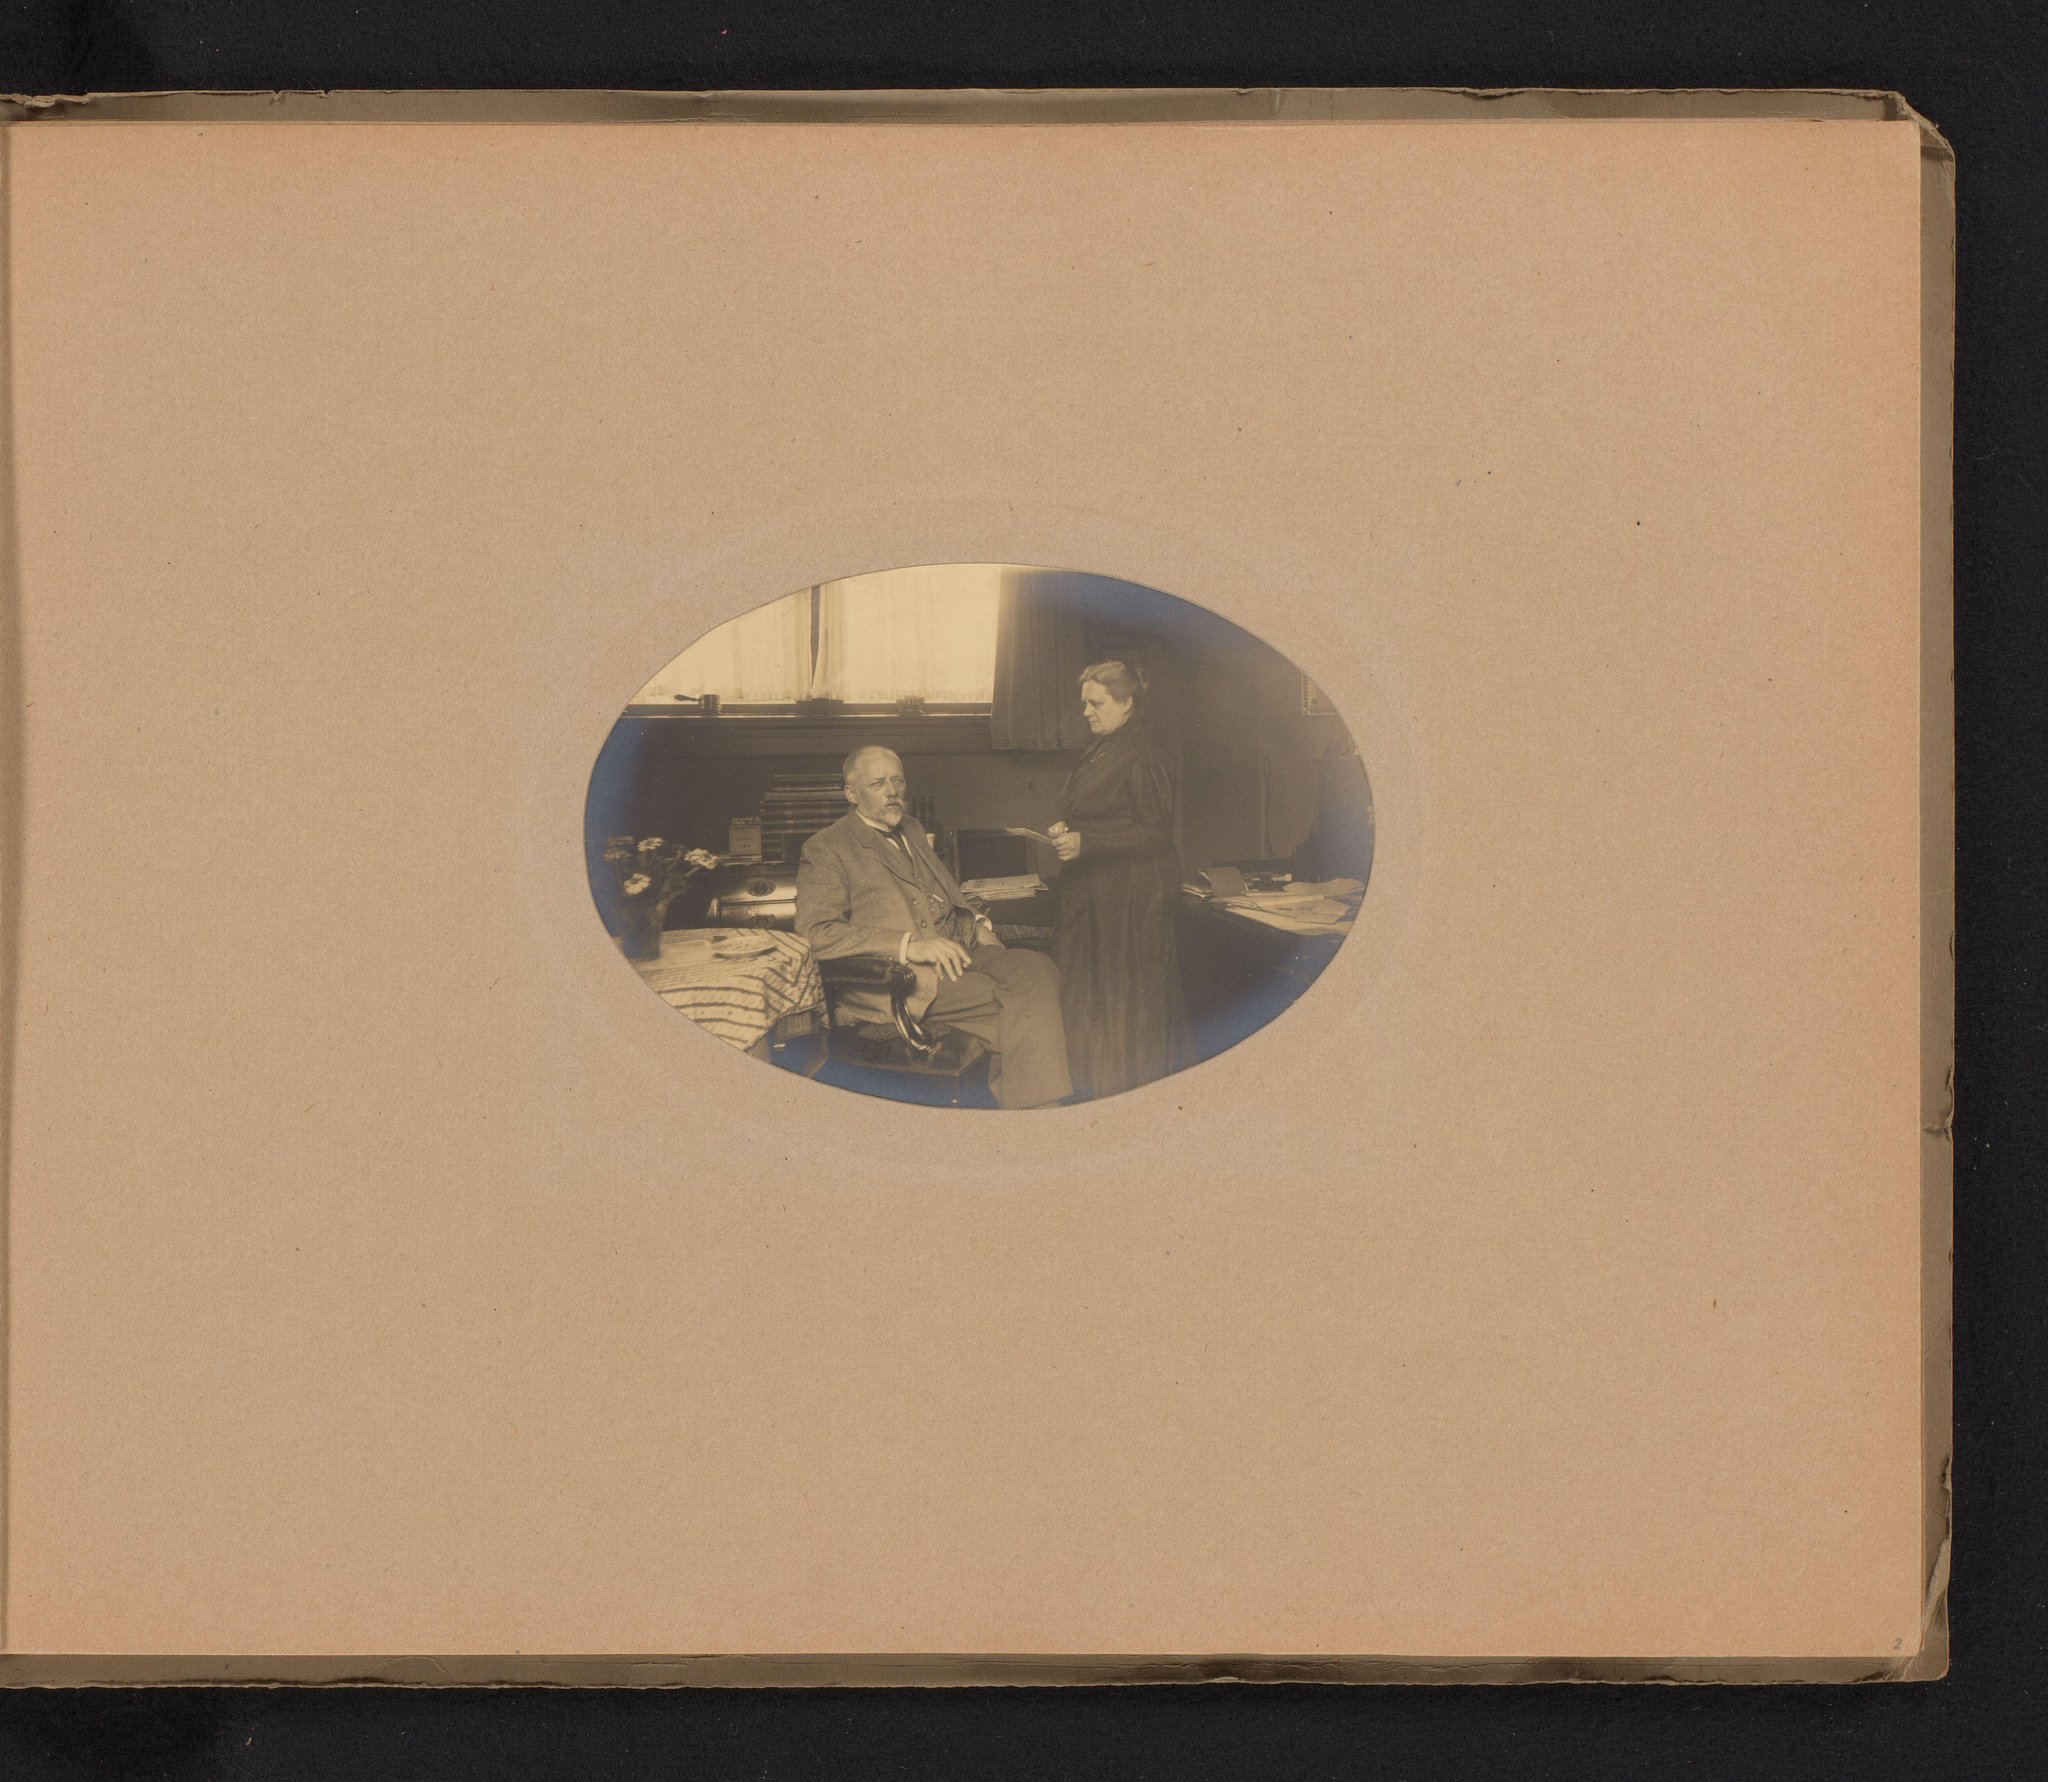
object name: album leaf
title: Portret van Lucas Jonker en Neletta Jonker-van der Linden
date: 1890-1915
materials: paper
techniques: gelatin silver print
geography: bussum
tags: amsterdam, haarlem, historical persons